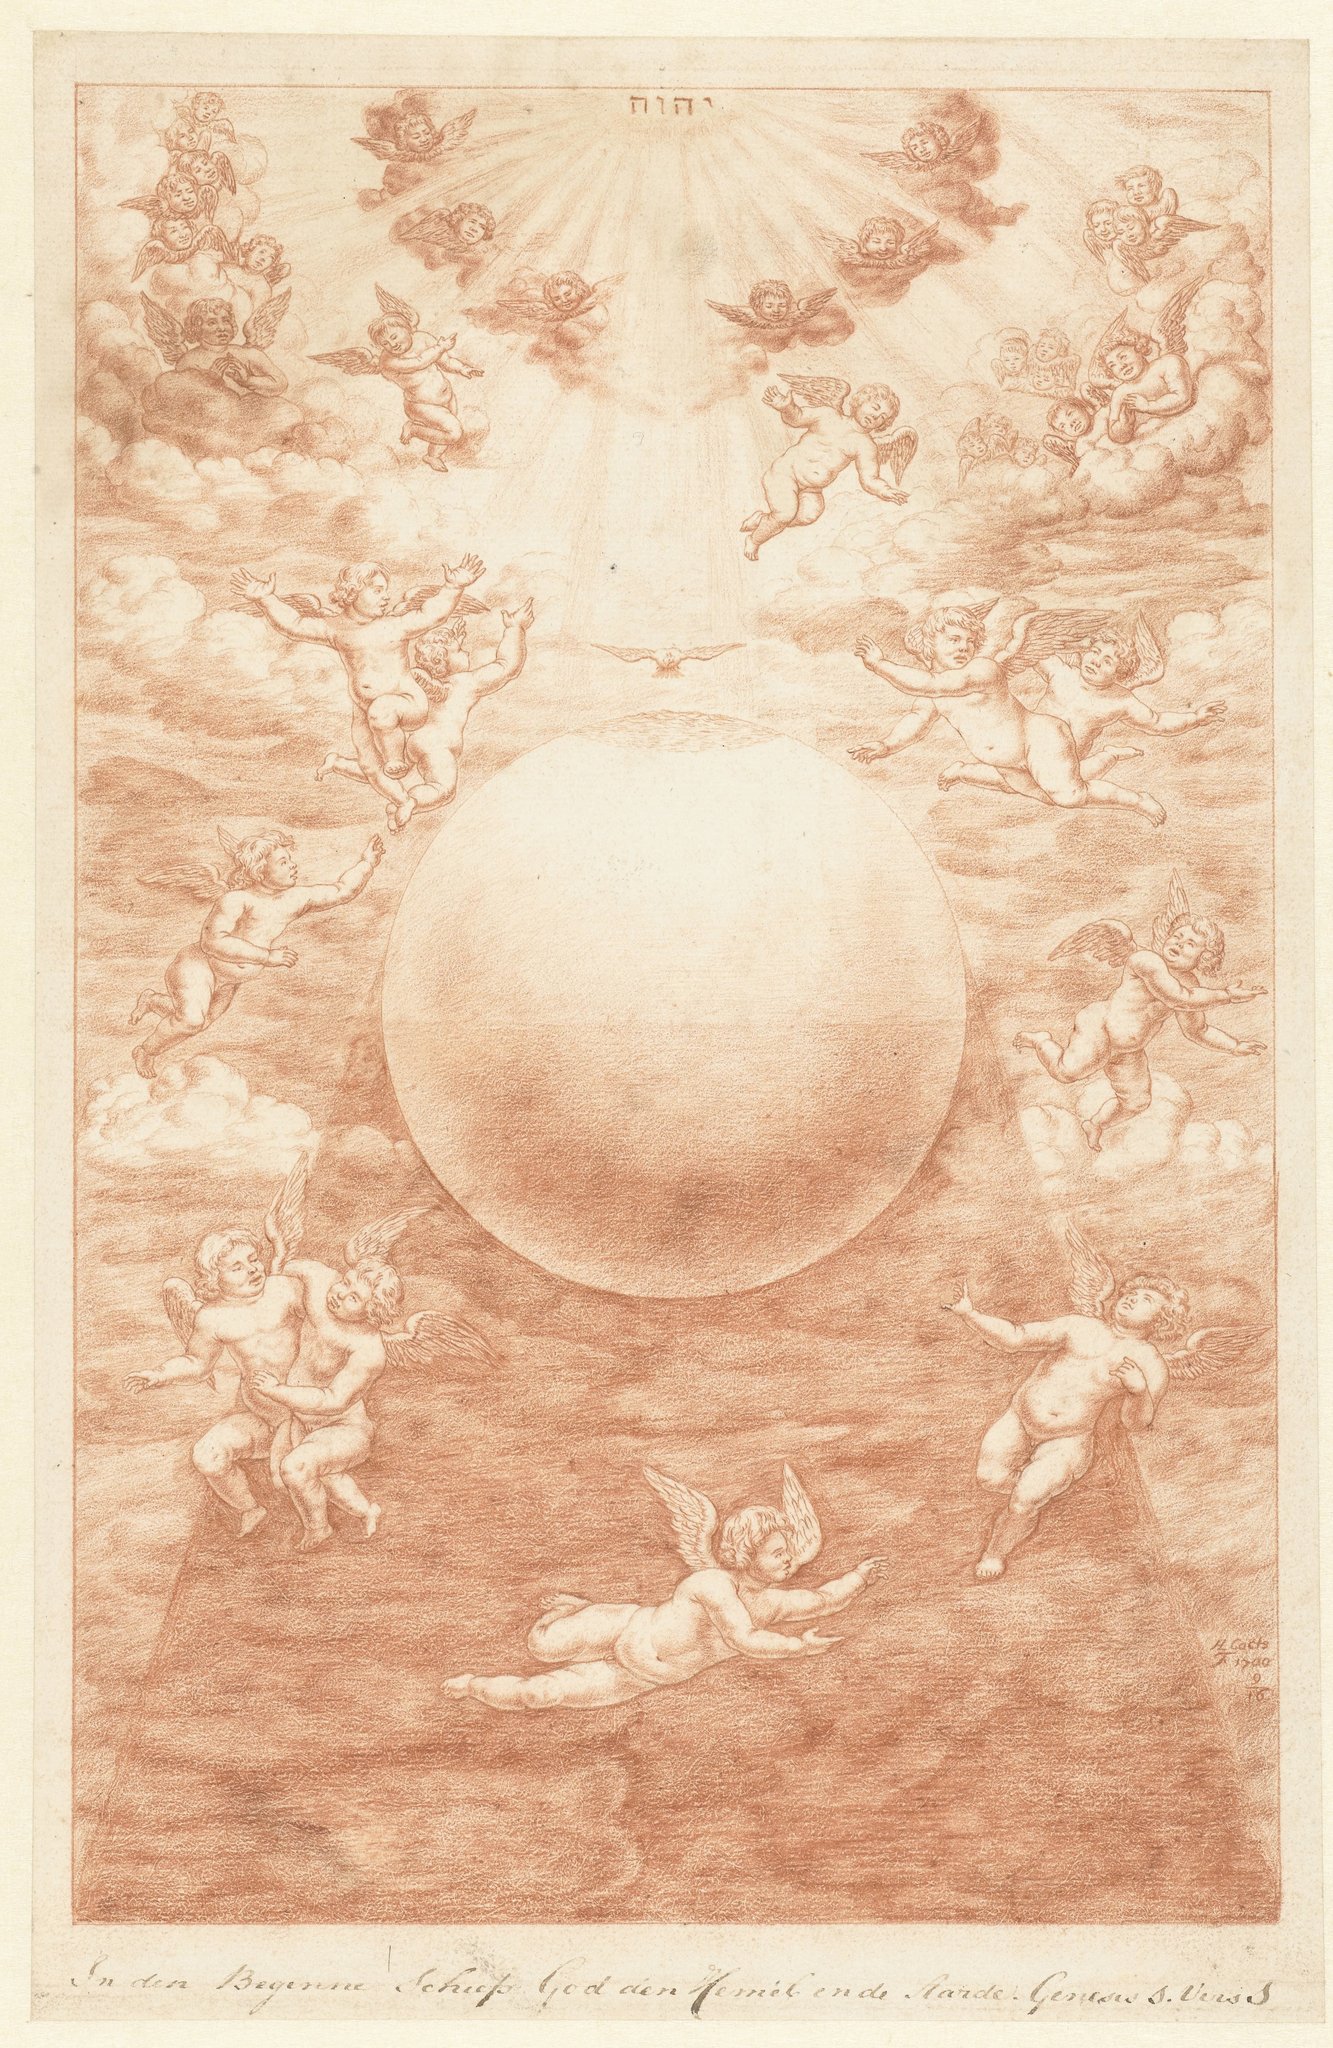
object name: design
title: In den beginne schiep God de hemel en de aarde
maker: herman coets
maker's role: draughtsman, print maker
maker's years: 1663-1711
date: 1700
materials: chalk, paper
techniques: pouncing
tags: creation of the firmament and division of the waters above and below it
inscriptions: date: ‘1700 9/16’